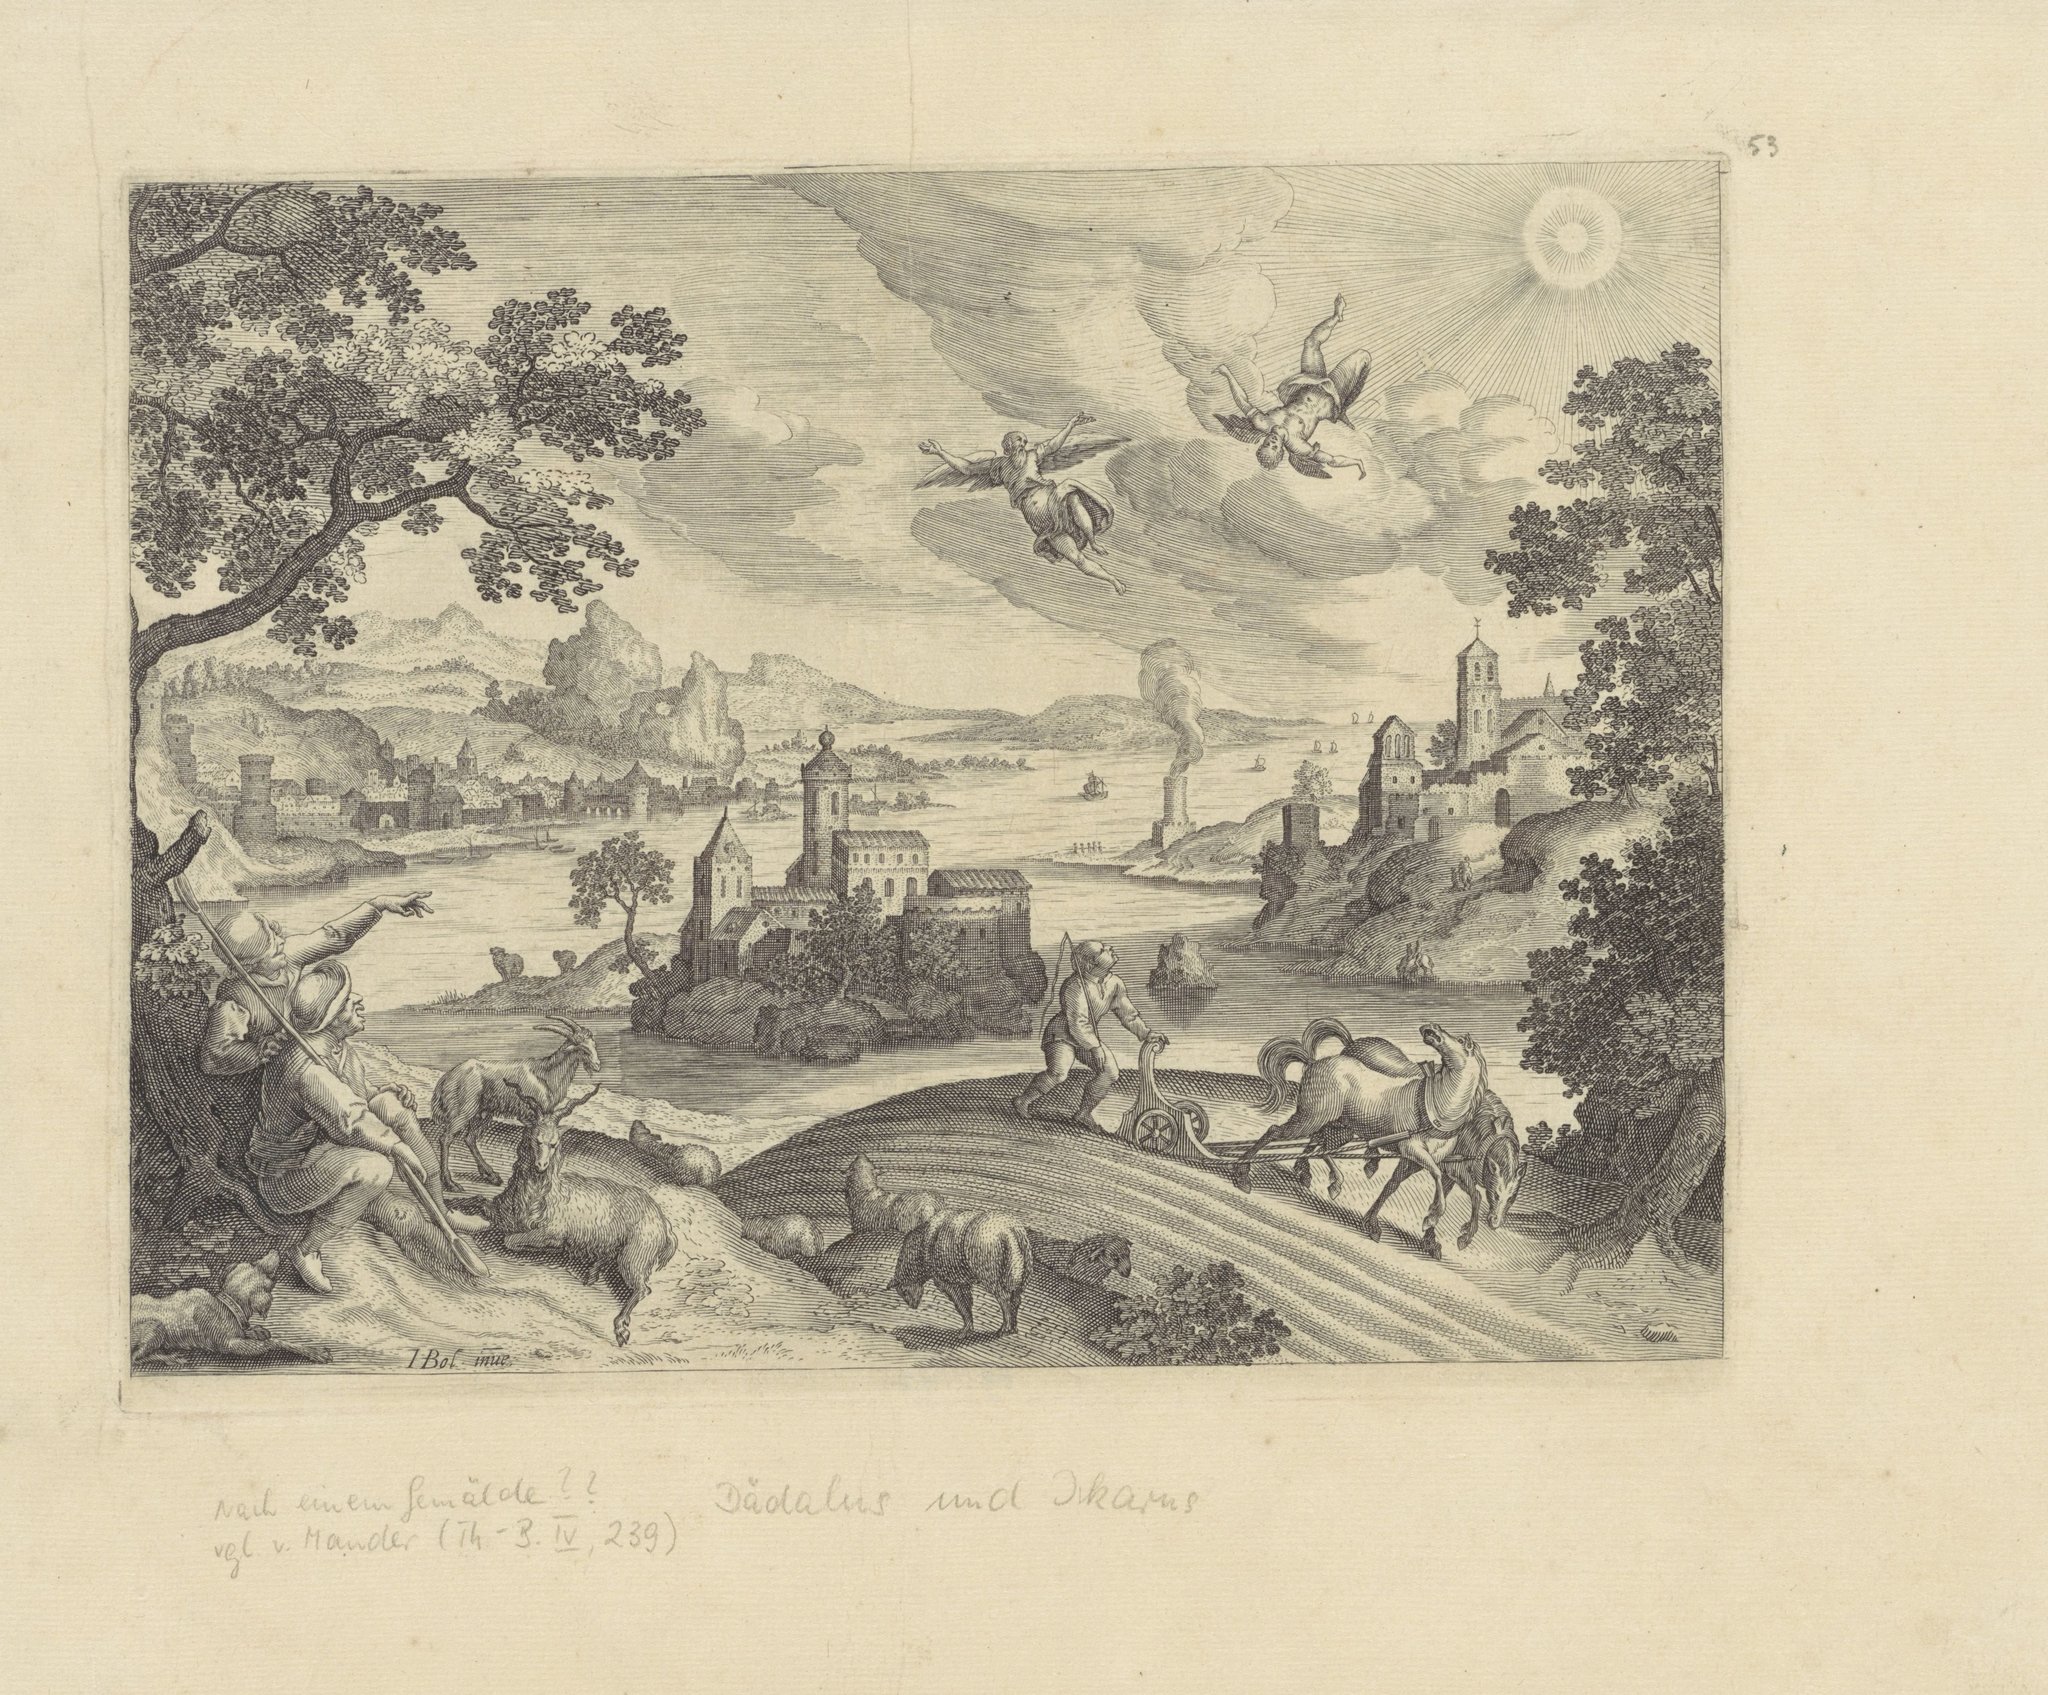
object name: print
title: Landschappen met verhalen uit Ovidius' Metamorphosen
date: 1550-1643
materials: paper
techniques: engraving, etching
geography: low countries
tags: herding, herdsman, herdswoman, shepherd, shepherdess, cowherd, etc., river (+ landscape with figures, staffage), the flight of daedalus and icarus, ploughing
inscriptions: collector's mark: Lugt 2228, collector's mark: Lugt 2760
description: Icarus stort neer, omdat zijn vleugels smelten door het zonlicht. Naast hem vliegt zijn vader Daedalus, die vertwijfeld toekijkt. Vooraan wijzen twee herders naar het tafereel. Voor hen graast hun kudde. Verderop ploegt een boer zijn akker. Op de achtergrond een rivierlandschap met bebouwde oevers en een kasteel op een eiland in het midden van de rivier.